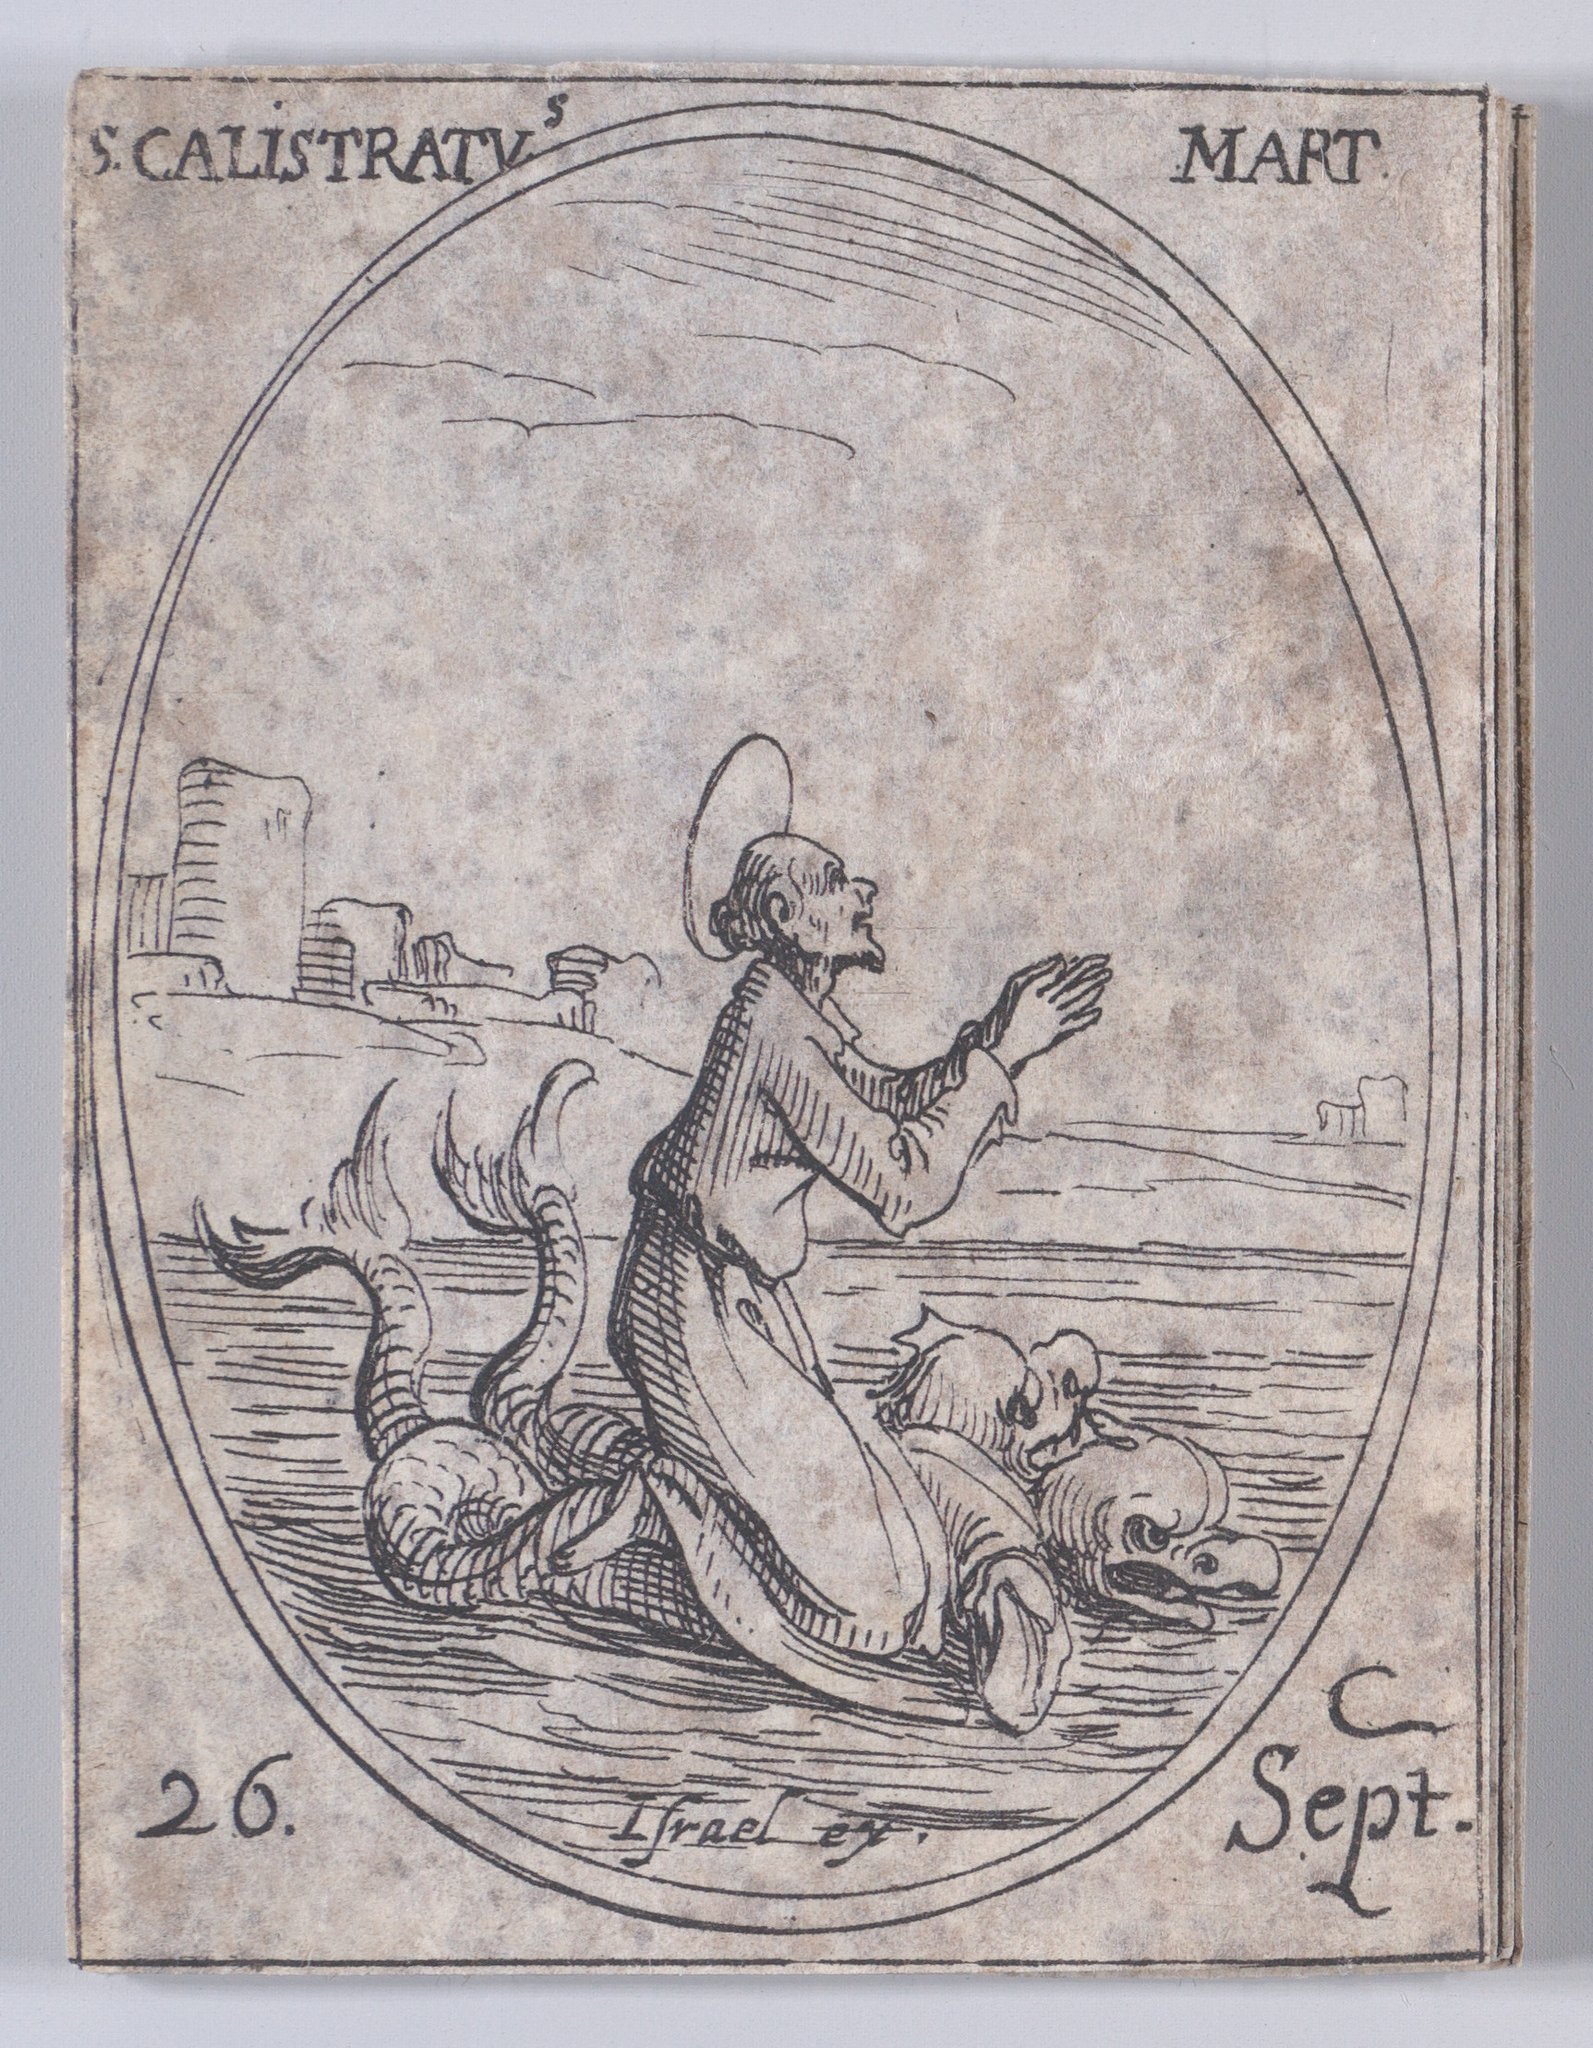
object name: print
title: S. Calistrate, martyr (St. Callistratus, Martyr), September 26th, from "Les Images De Tous Les Saincts et Saintes de L'Année" (Images of All of the Saints and Religious Events of the Year)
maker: jacques callot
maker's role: artist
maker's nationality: french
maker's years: 1592-1635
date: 1636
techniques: etching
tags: men,saints